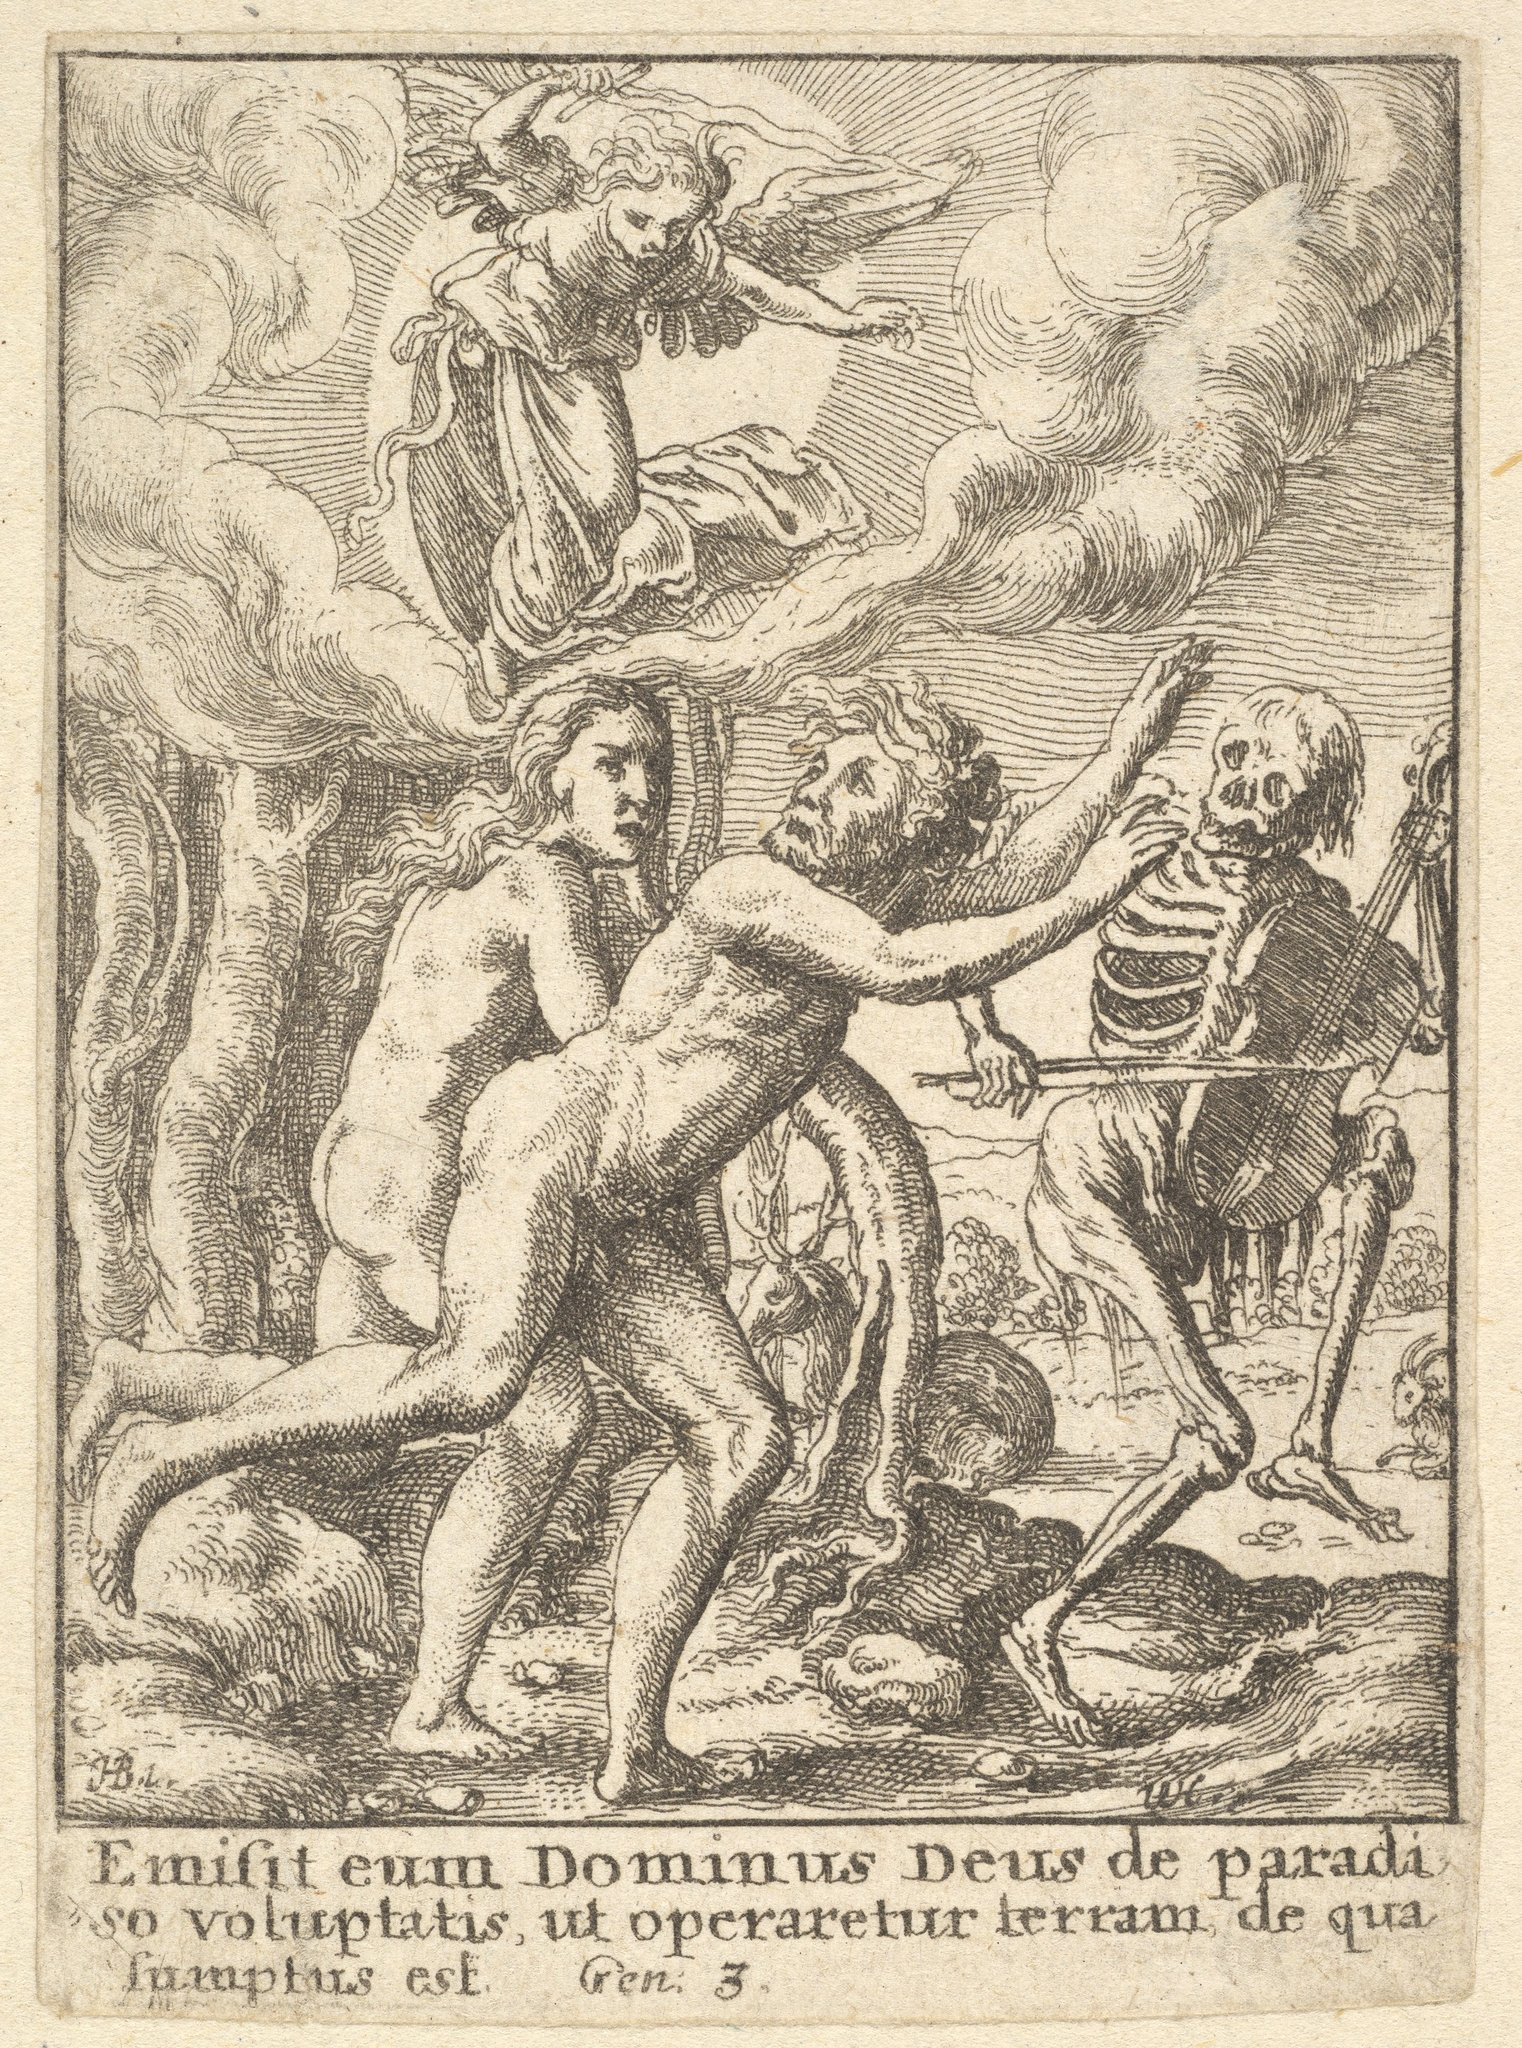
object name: print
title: Paradise Lost, from the Dance of Death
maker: wenceslaus hollar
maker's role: artist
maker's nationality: bohemian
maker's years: 1607-1677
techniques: etching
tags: skeletons,male nudes,female nudes,violas